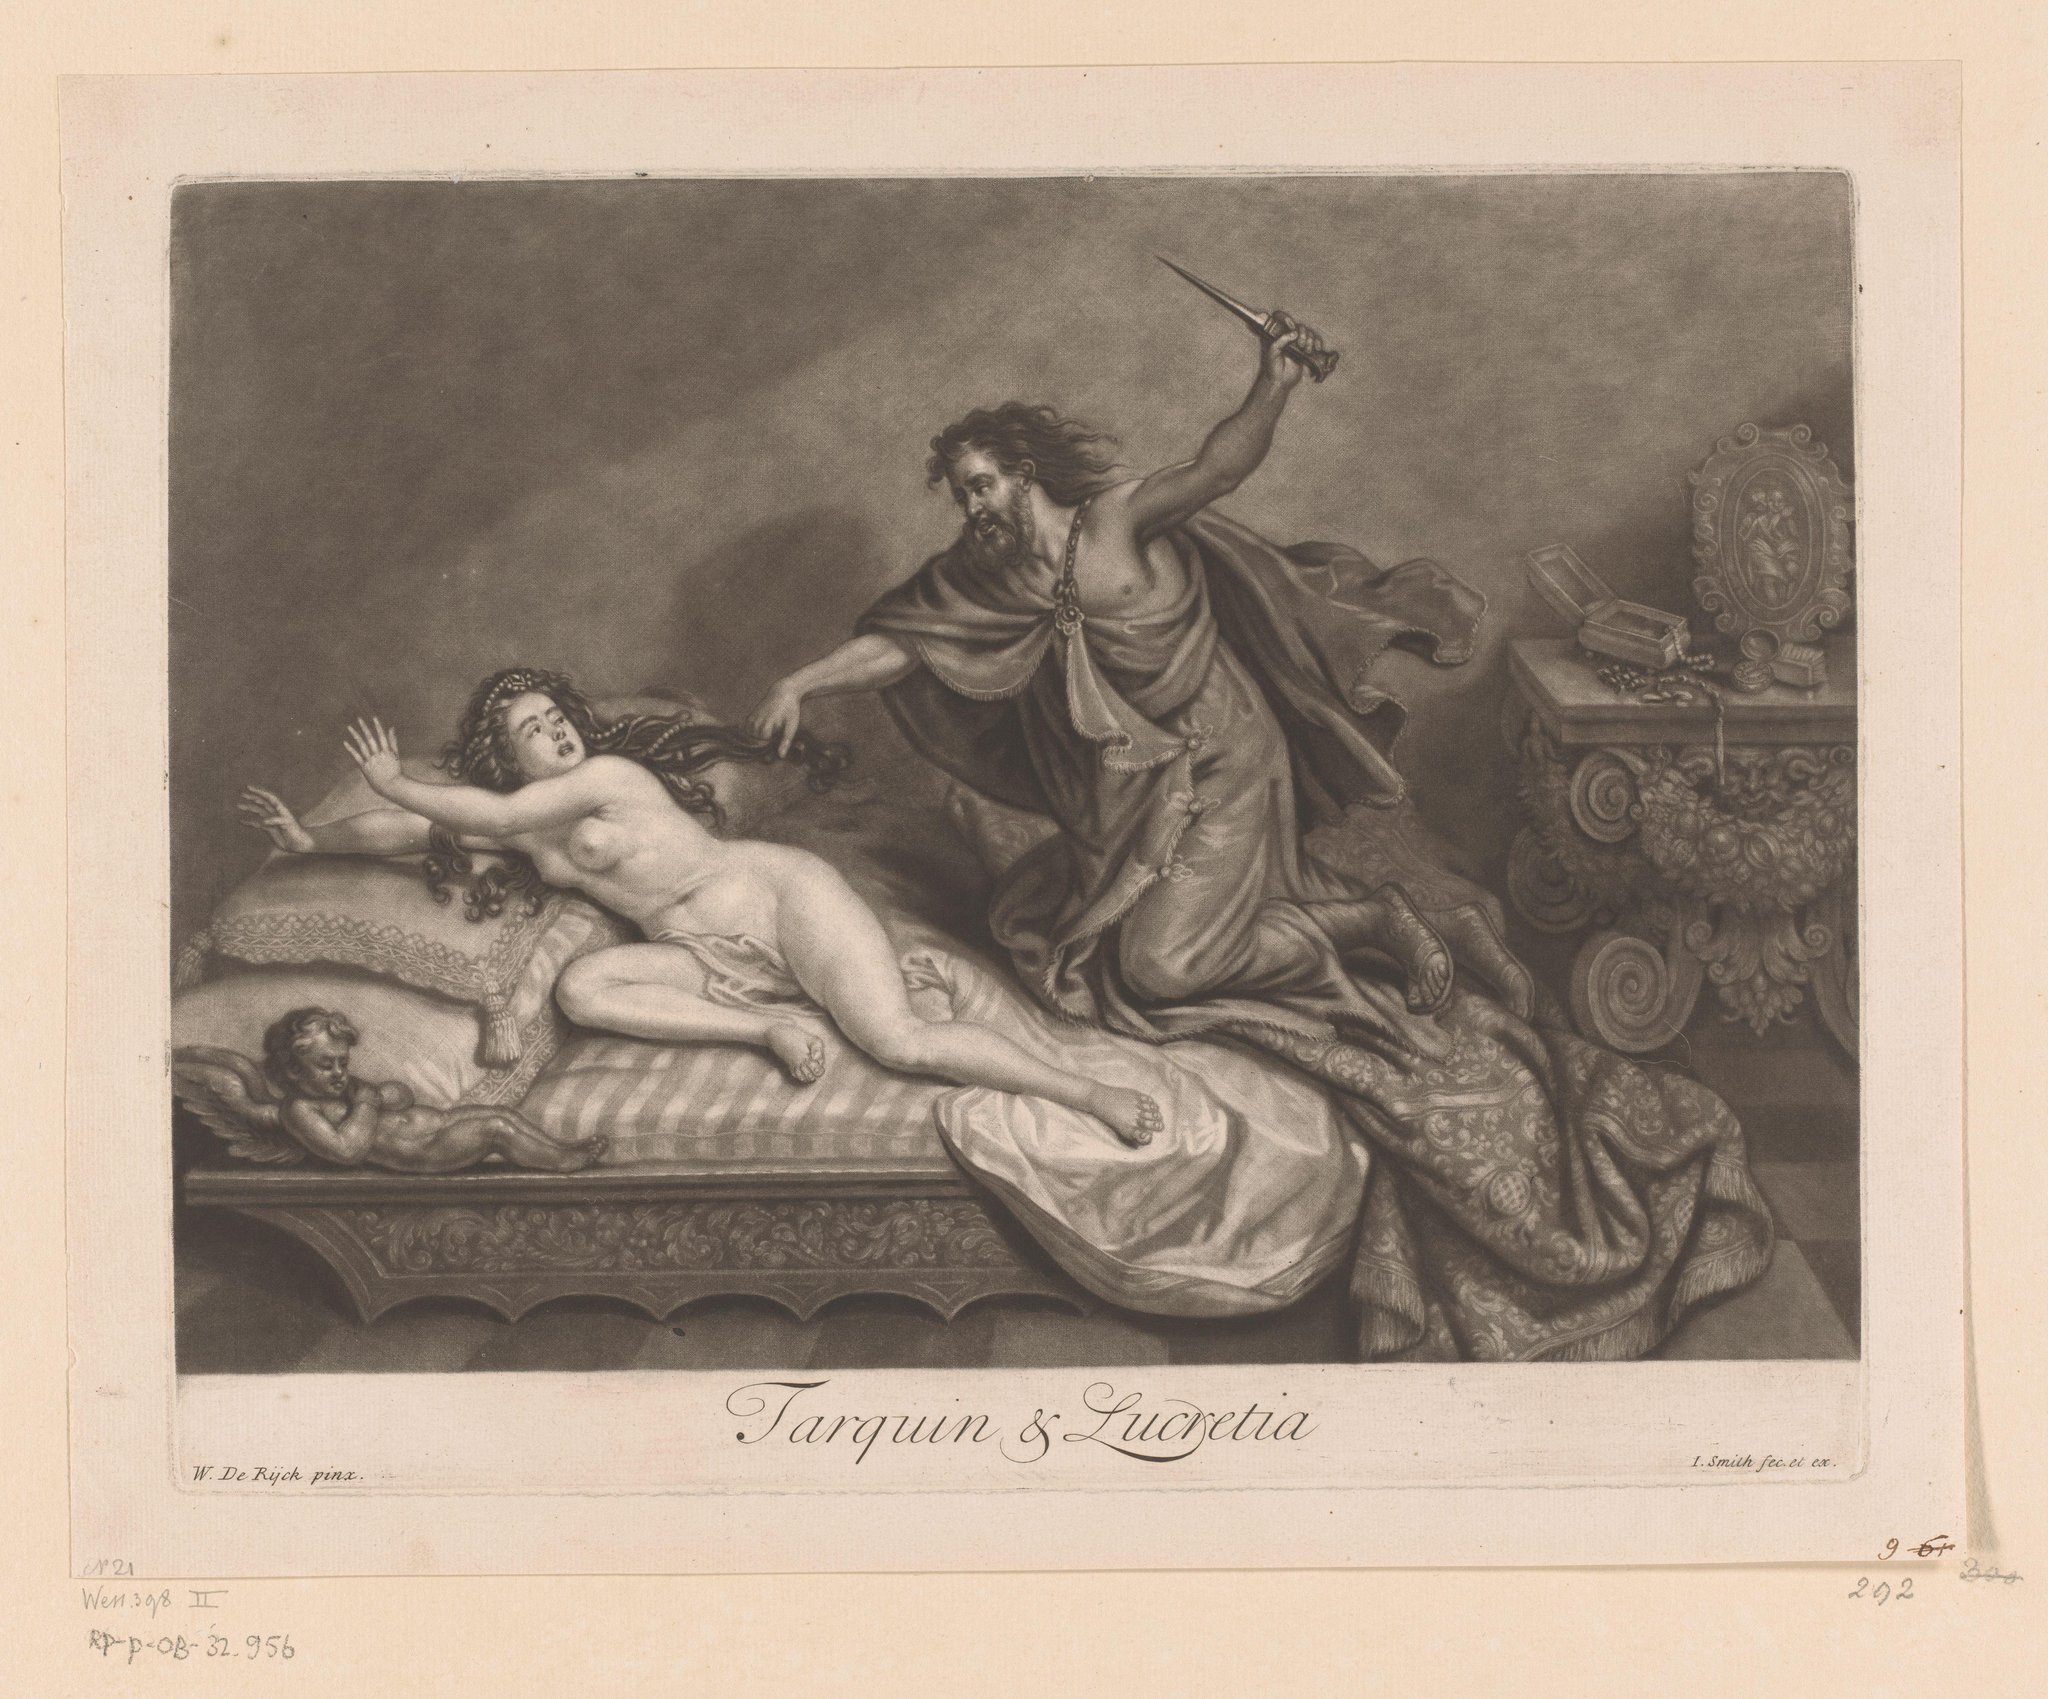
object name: print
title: Verkrachting van Lucretia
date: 1662-1742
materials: paper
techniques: mezzotint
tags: (story of) lucretia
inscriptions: collector's mark: Lugt 240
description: Lucretia, naakt in bed, probeert weg te komen van de aanvallende Sextus Tarquinius met een dolk.